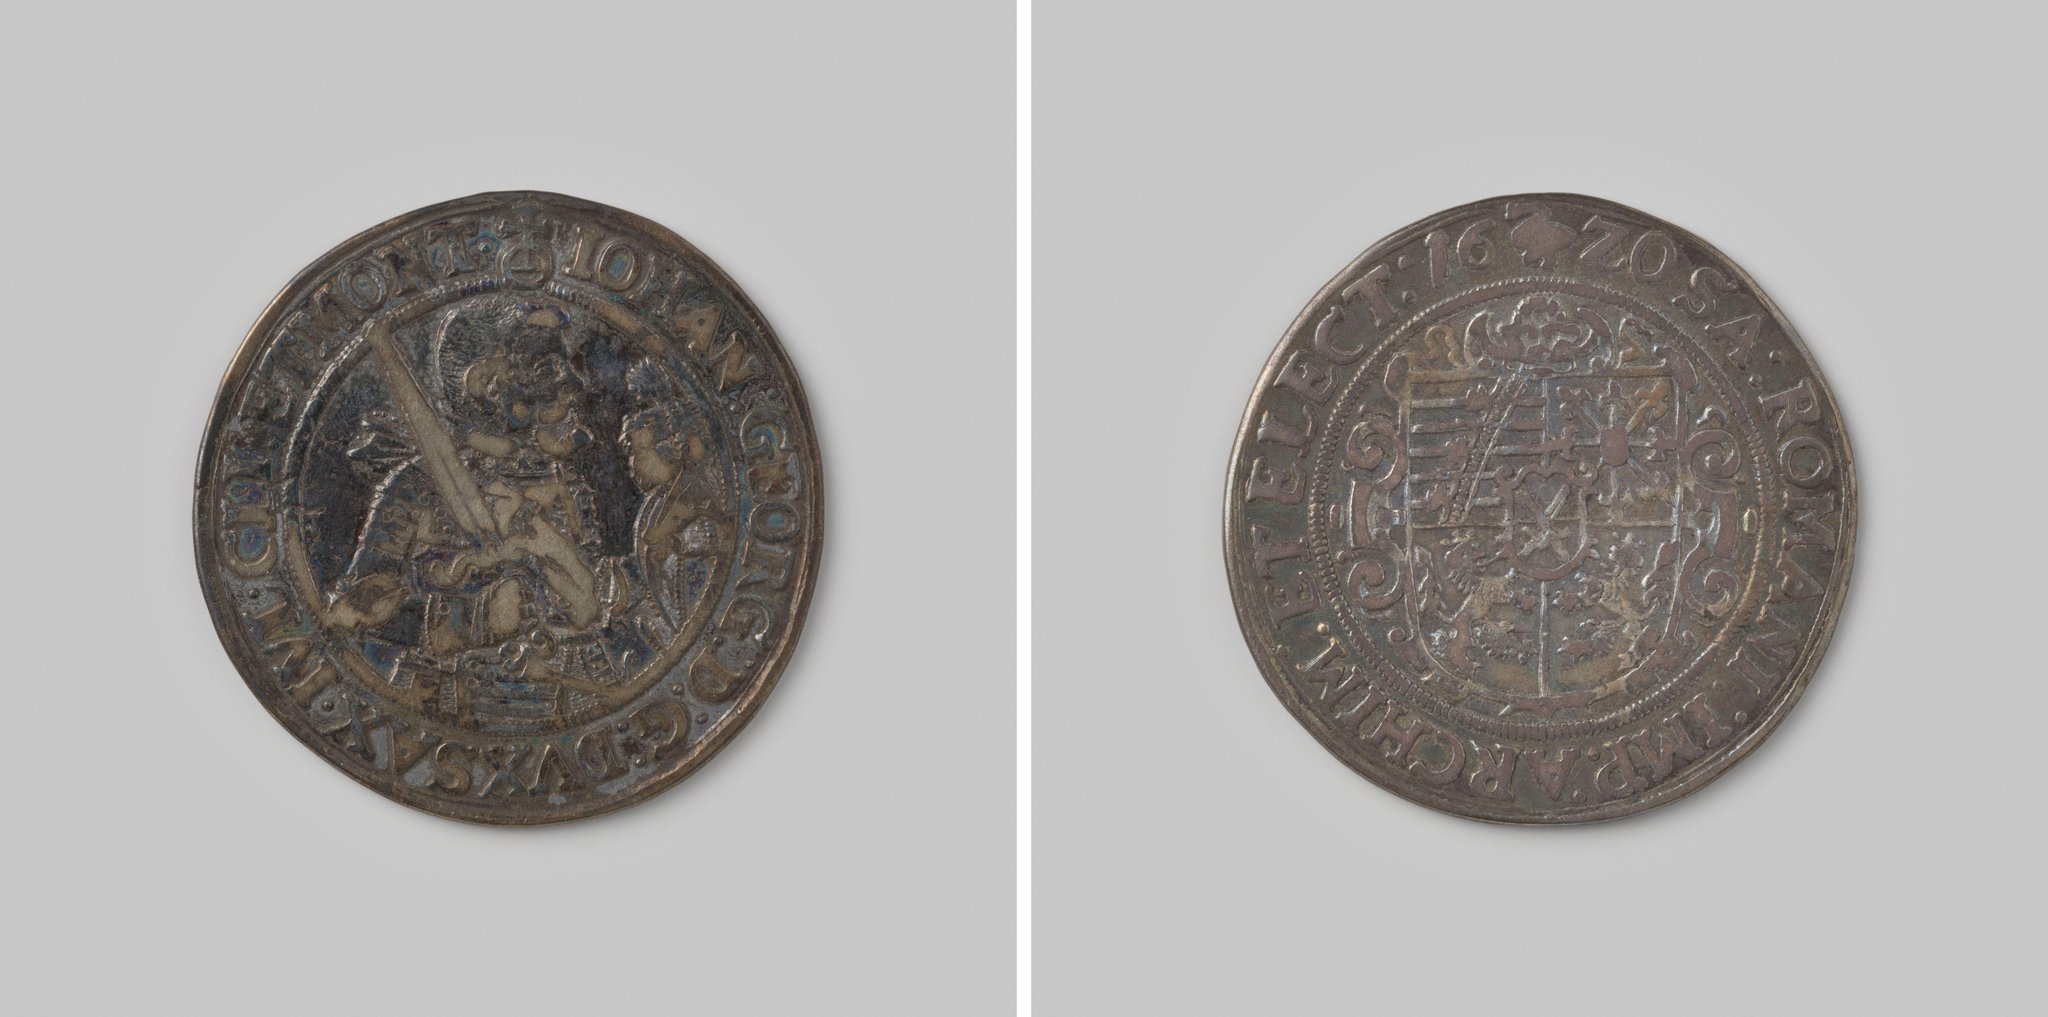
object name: kwart taler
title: Saksen, Albertinische Linie, Johann Georg I, 1/4 Taler,1620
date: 1620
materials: silver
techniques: striking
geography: dresden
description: Zilveren munt. Voorzijde: portret van de keurvorst naar rechts met in rechterhand zwaard. Keerzijde: Versierd samengesteld wapenschild. Jaartal in omschrift bovenaan, onderbroken door zwaan